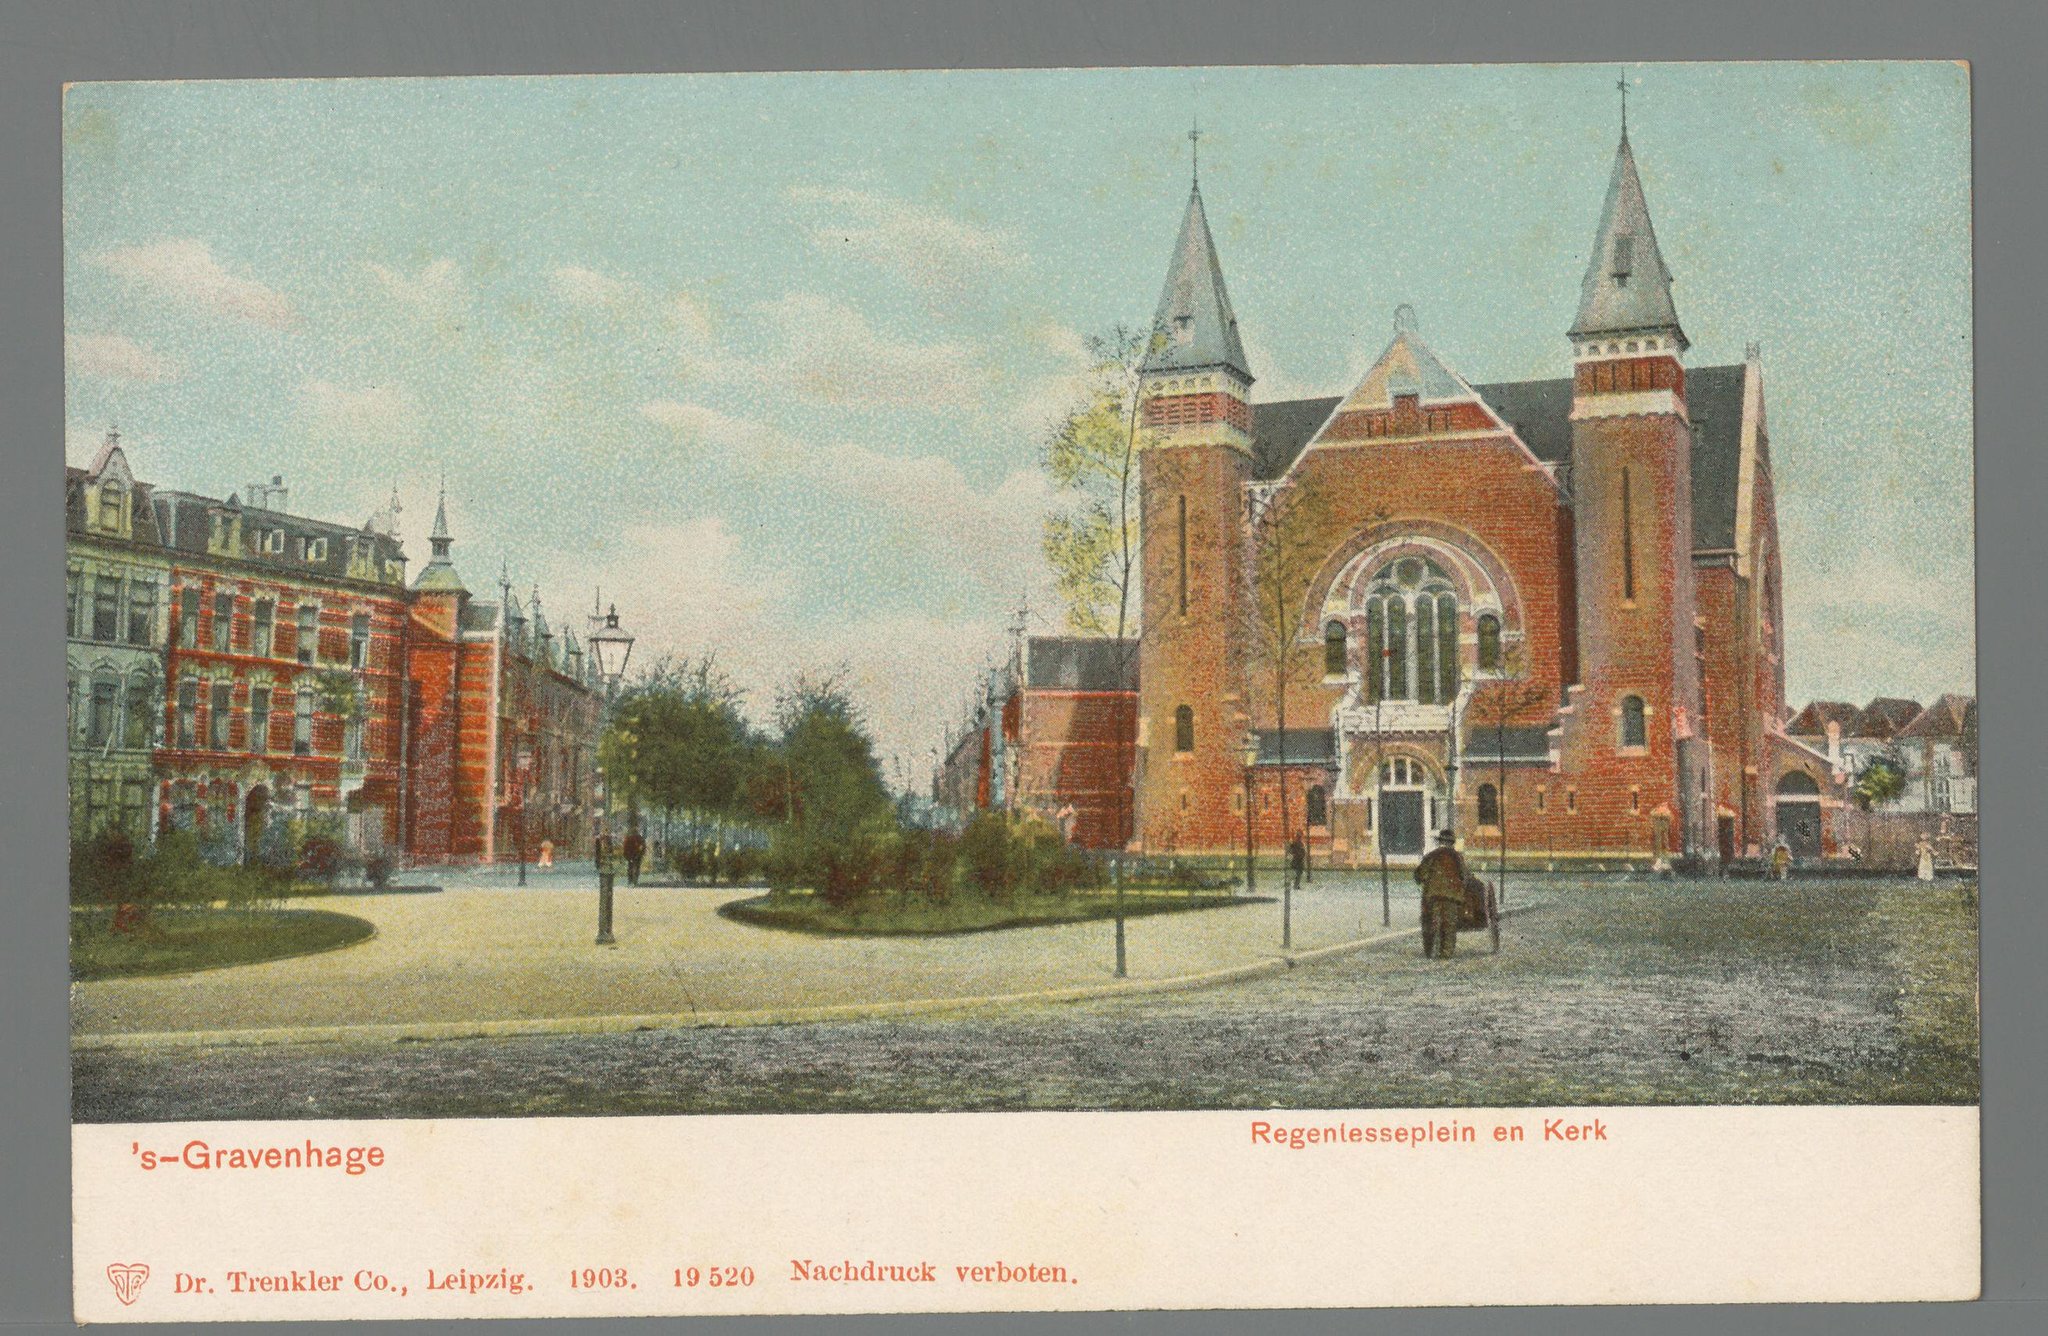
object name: ansichtkaart, prentbriefkaart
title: 's-Gravenhage. Regentesseplein en Kerk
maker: Anonymous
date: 1903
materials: cardboard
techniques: lithograph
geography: leipzig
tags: city-view, and landscape with man-made constructions, church (exterior)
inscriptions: date